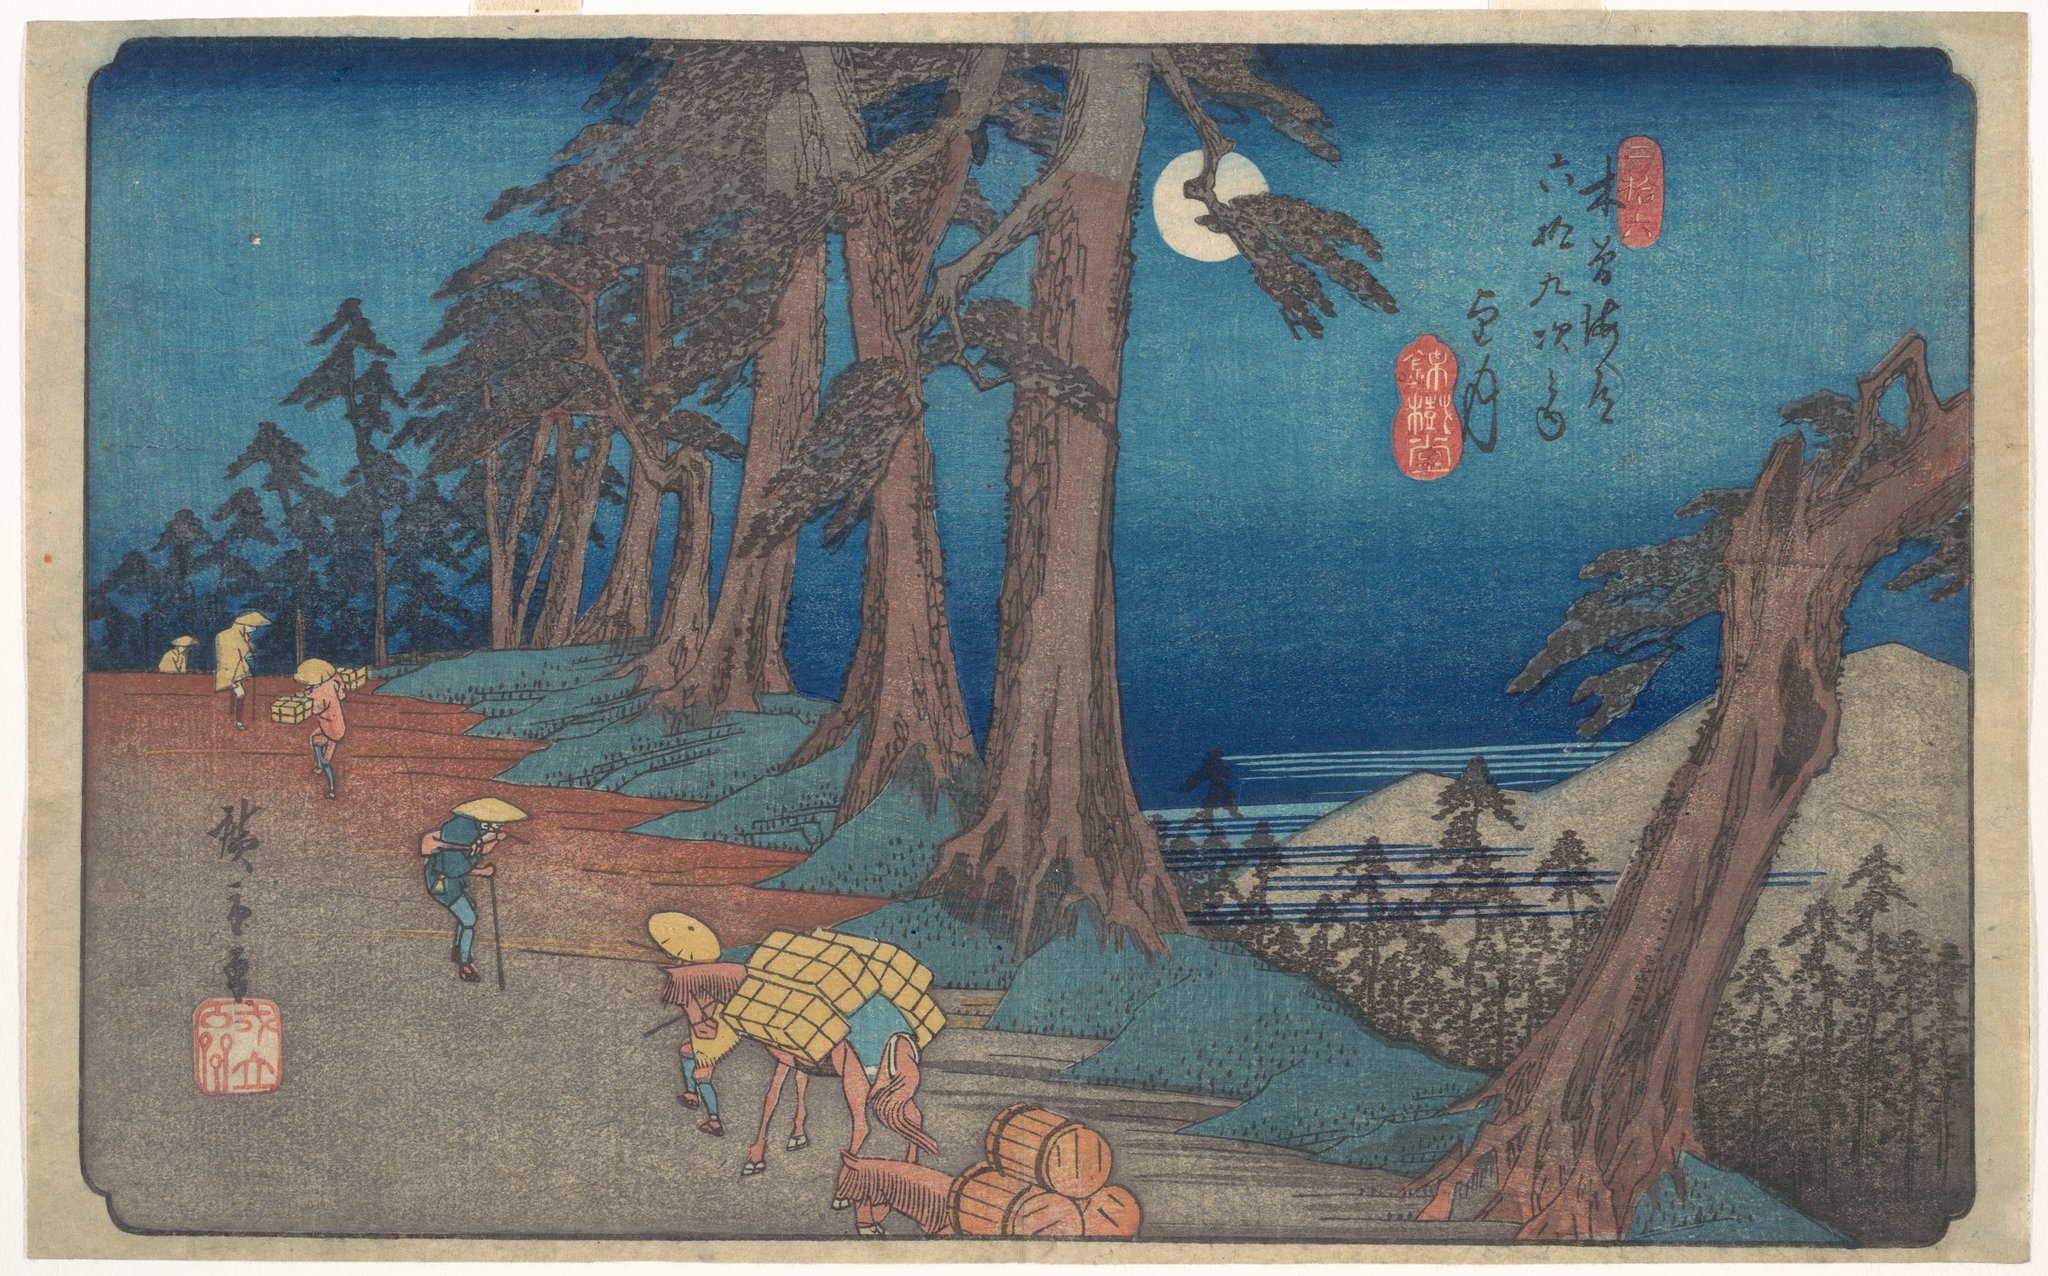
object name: print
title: Mochizuki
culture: japanese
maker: utagawa hiroshige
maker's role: artist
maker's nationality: japanese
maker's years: 1797-1858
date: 1797-1858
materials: ink, paper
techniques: woodblock print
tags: men,donkeys,moon,trees